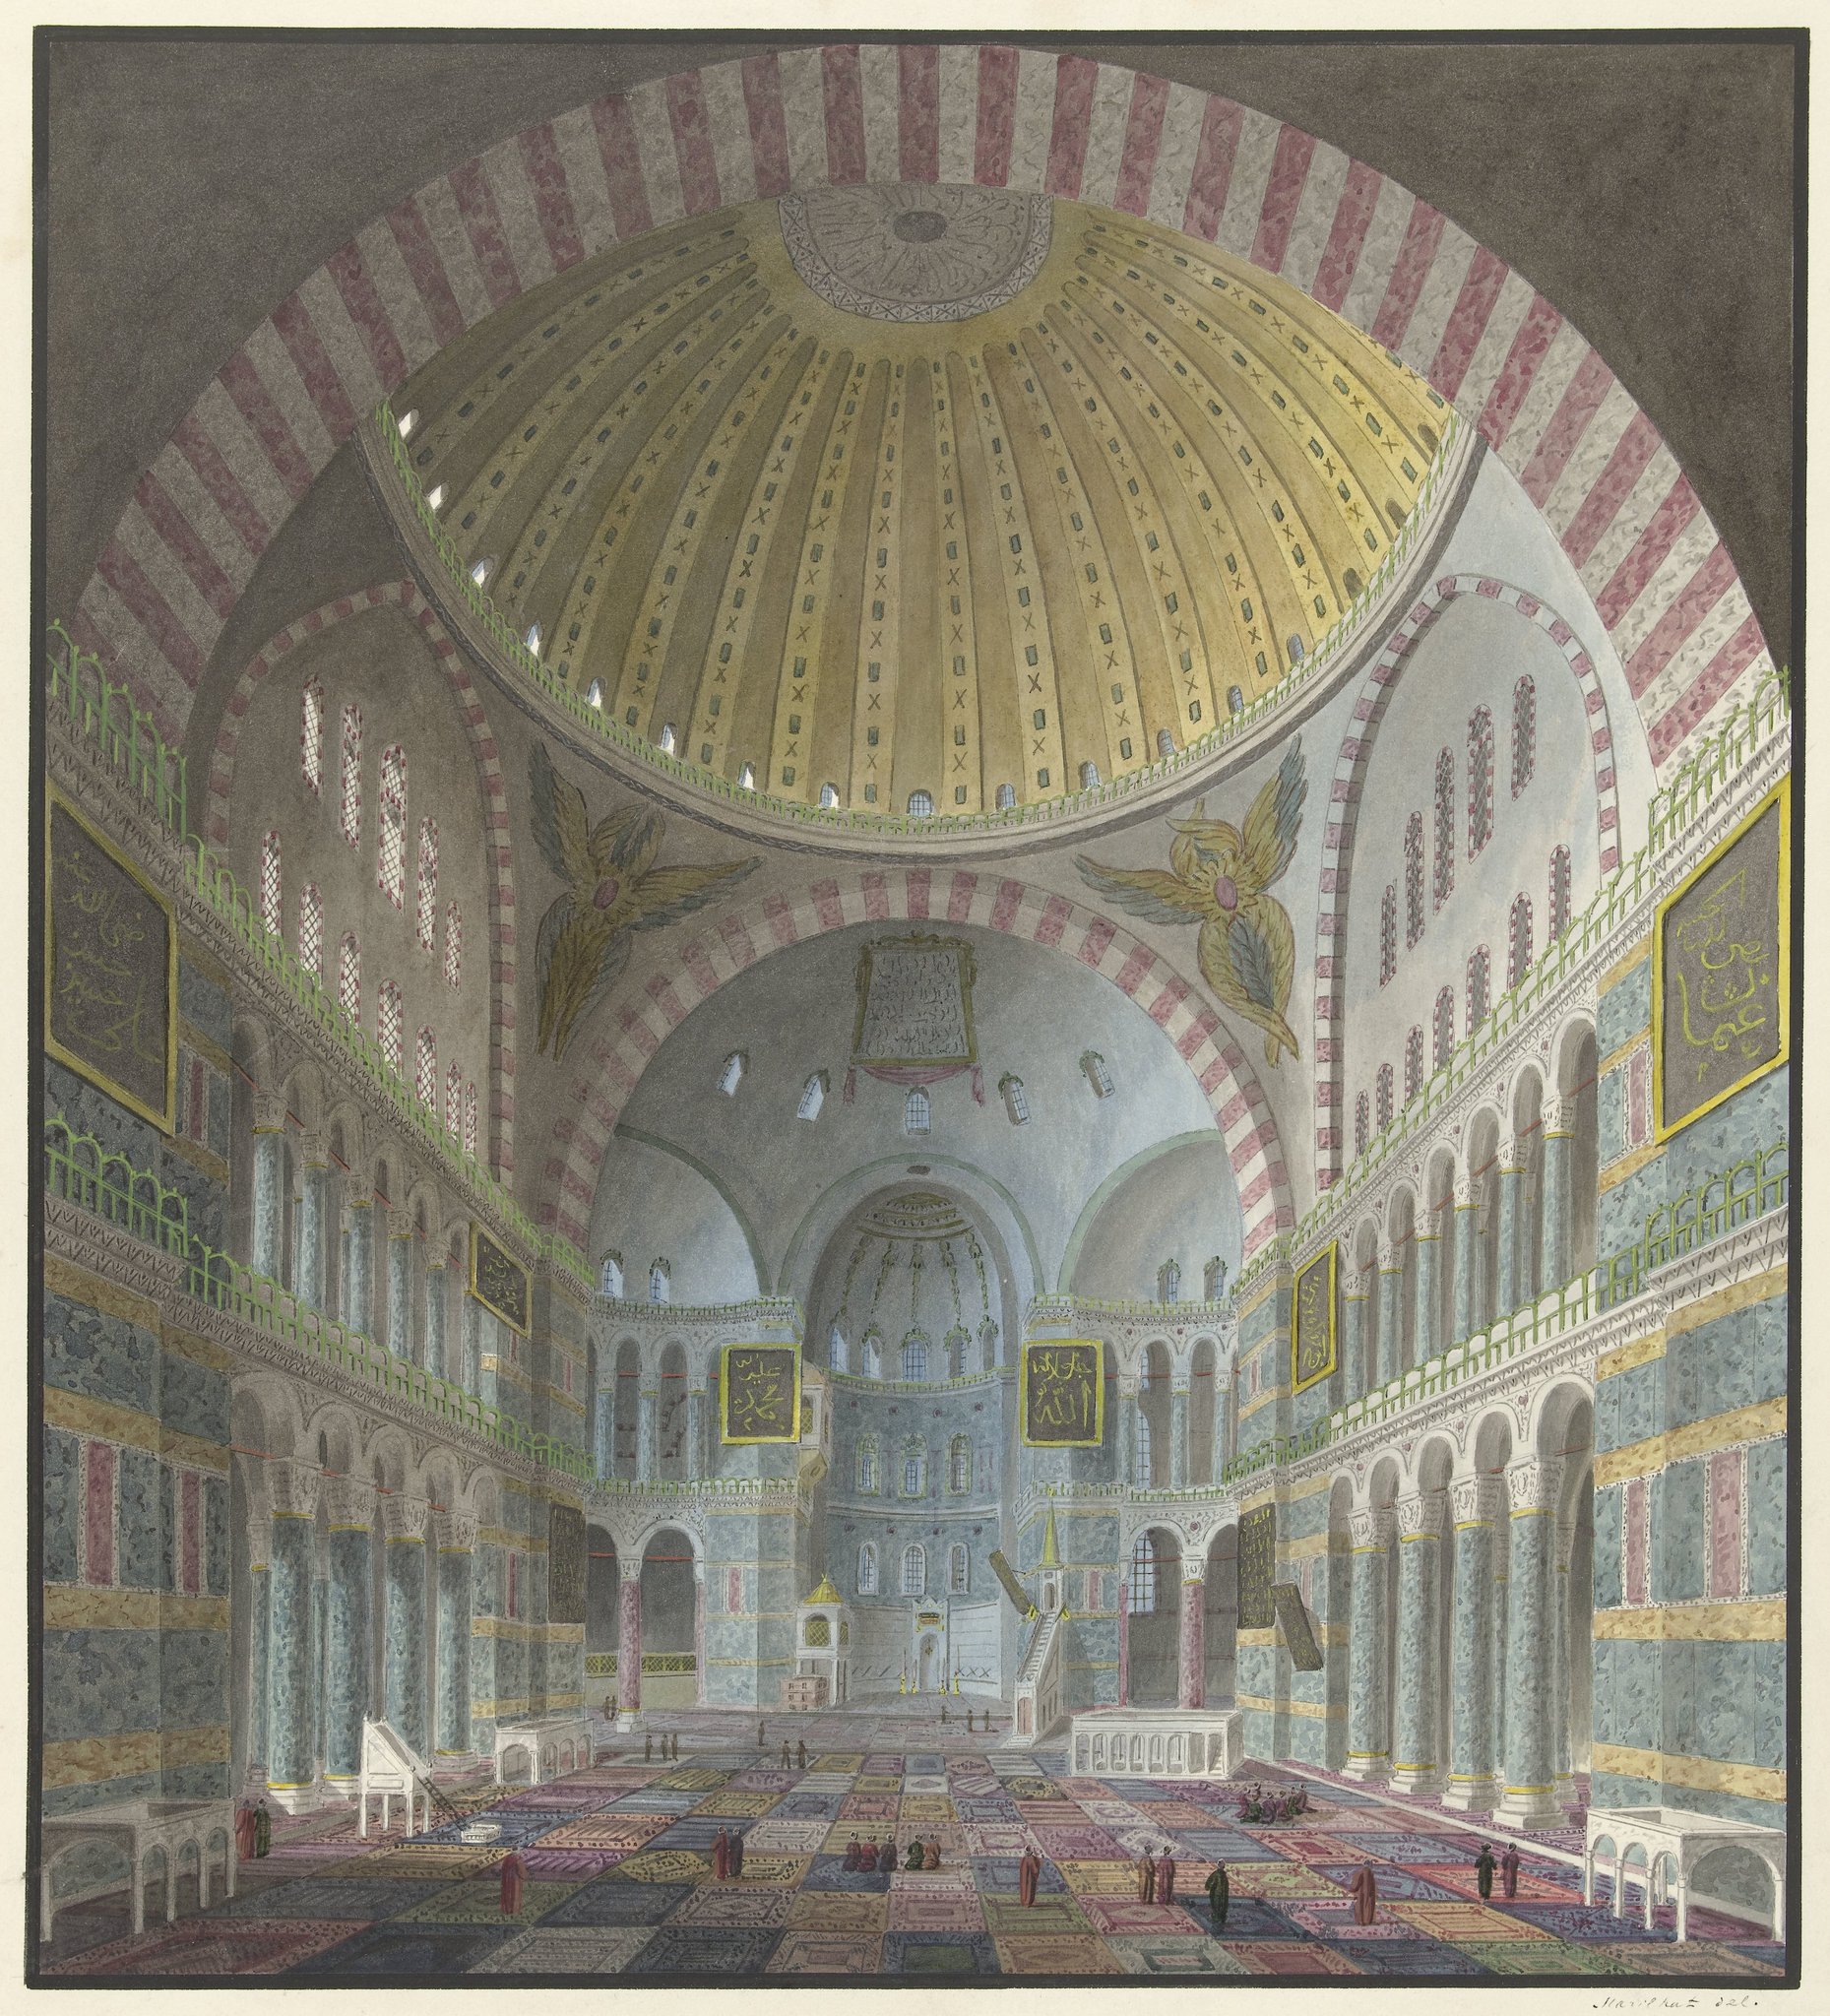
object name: drawing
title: Interieur van de Aya Sophia met geknielde en staande Turken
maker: george antoine prosper marilhat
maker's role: draughtsman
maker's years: 1811-1847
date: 1821-1847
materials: ink, paper, watercolor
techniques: brush, pen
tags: temple, shrine ~ islam, mohammedanism